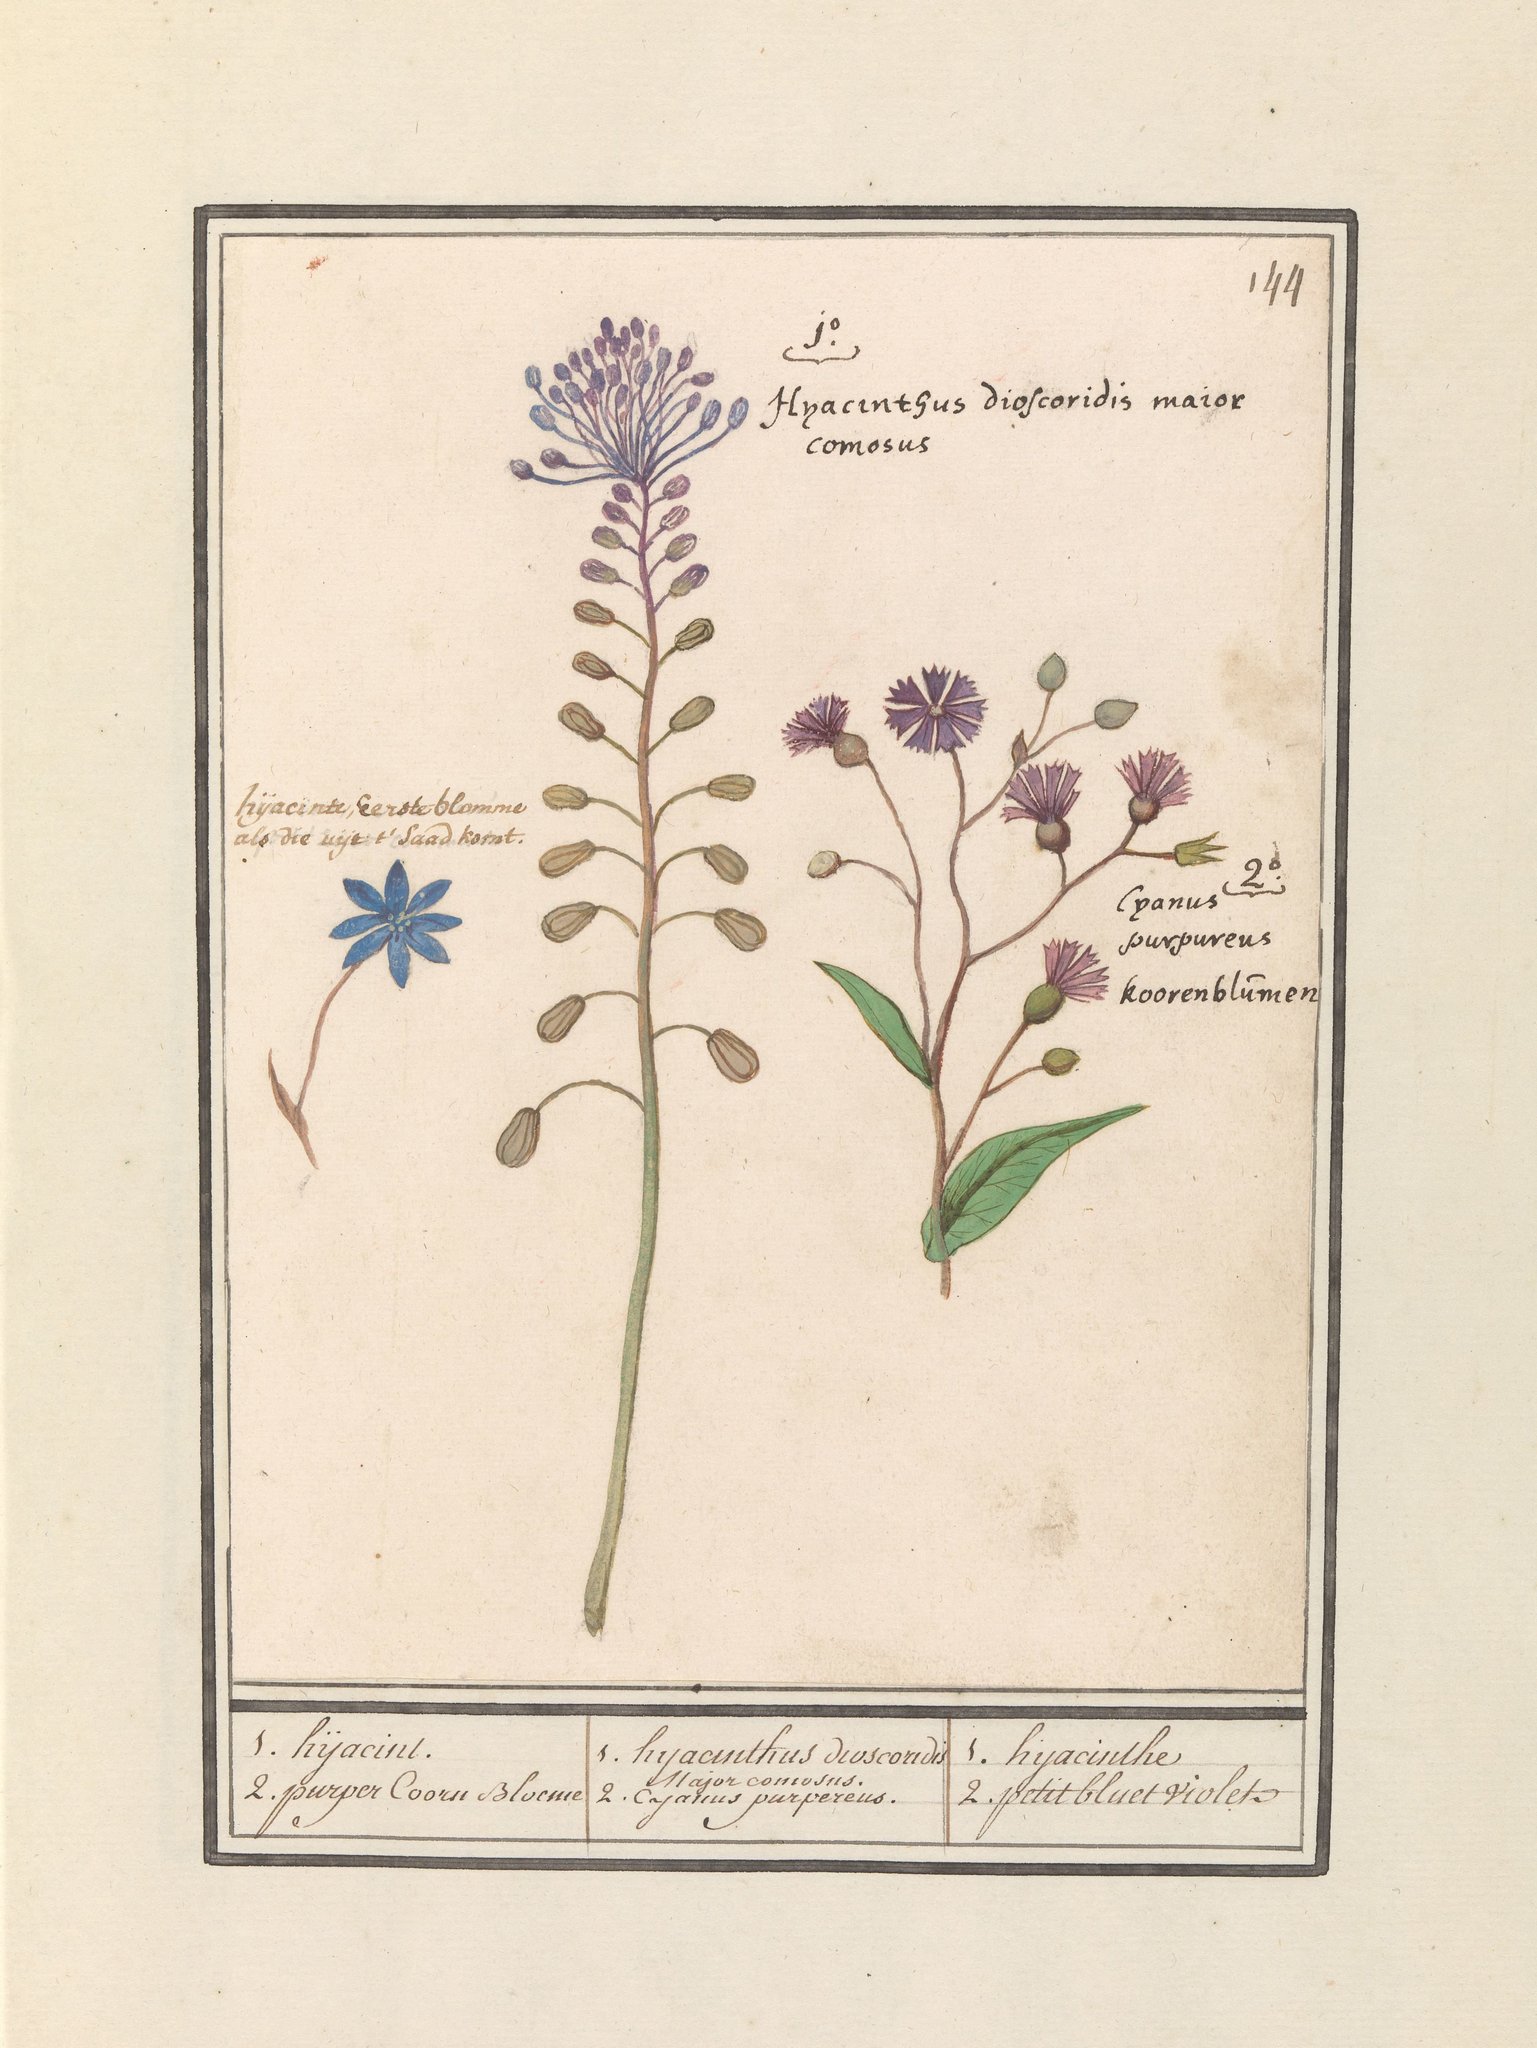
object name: drawing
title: 1. hijacint. 2. purper Coorn Bloeme / 1. hyacinthus dioscoridis. Major comosus. 2. cajanus purpereus. / 1. hyacinthe 2. petit bluet violet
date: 1596-1610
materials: chalk, paint, ink, paper, watercolor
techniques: brush, pen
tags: flowers: cornflower, flowers: hyacinth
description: Kuifhyacint en een paarse korenbloem of centauri. Rechtsboven genummerd: 144. Bij de bloemen de Latijnse namen en een opschrift in het Nederlands. Onderdeel van het tweede album met tekeningen van bloemen en planten. Negende van twaalf albums met tekeningen van dieren, vogels en planten bekend rond 1600, gemaakt in opdracht van keizer Rudolf II. Met toelichting in Nederlands, Latijn en Frans.